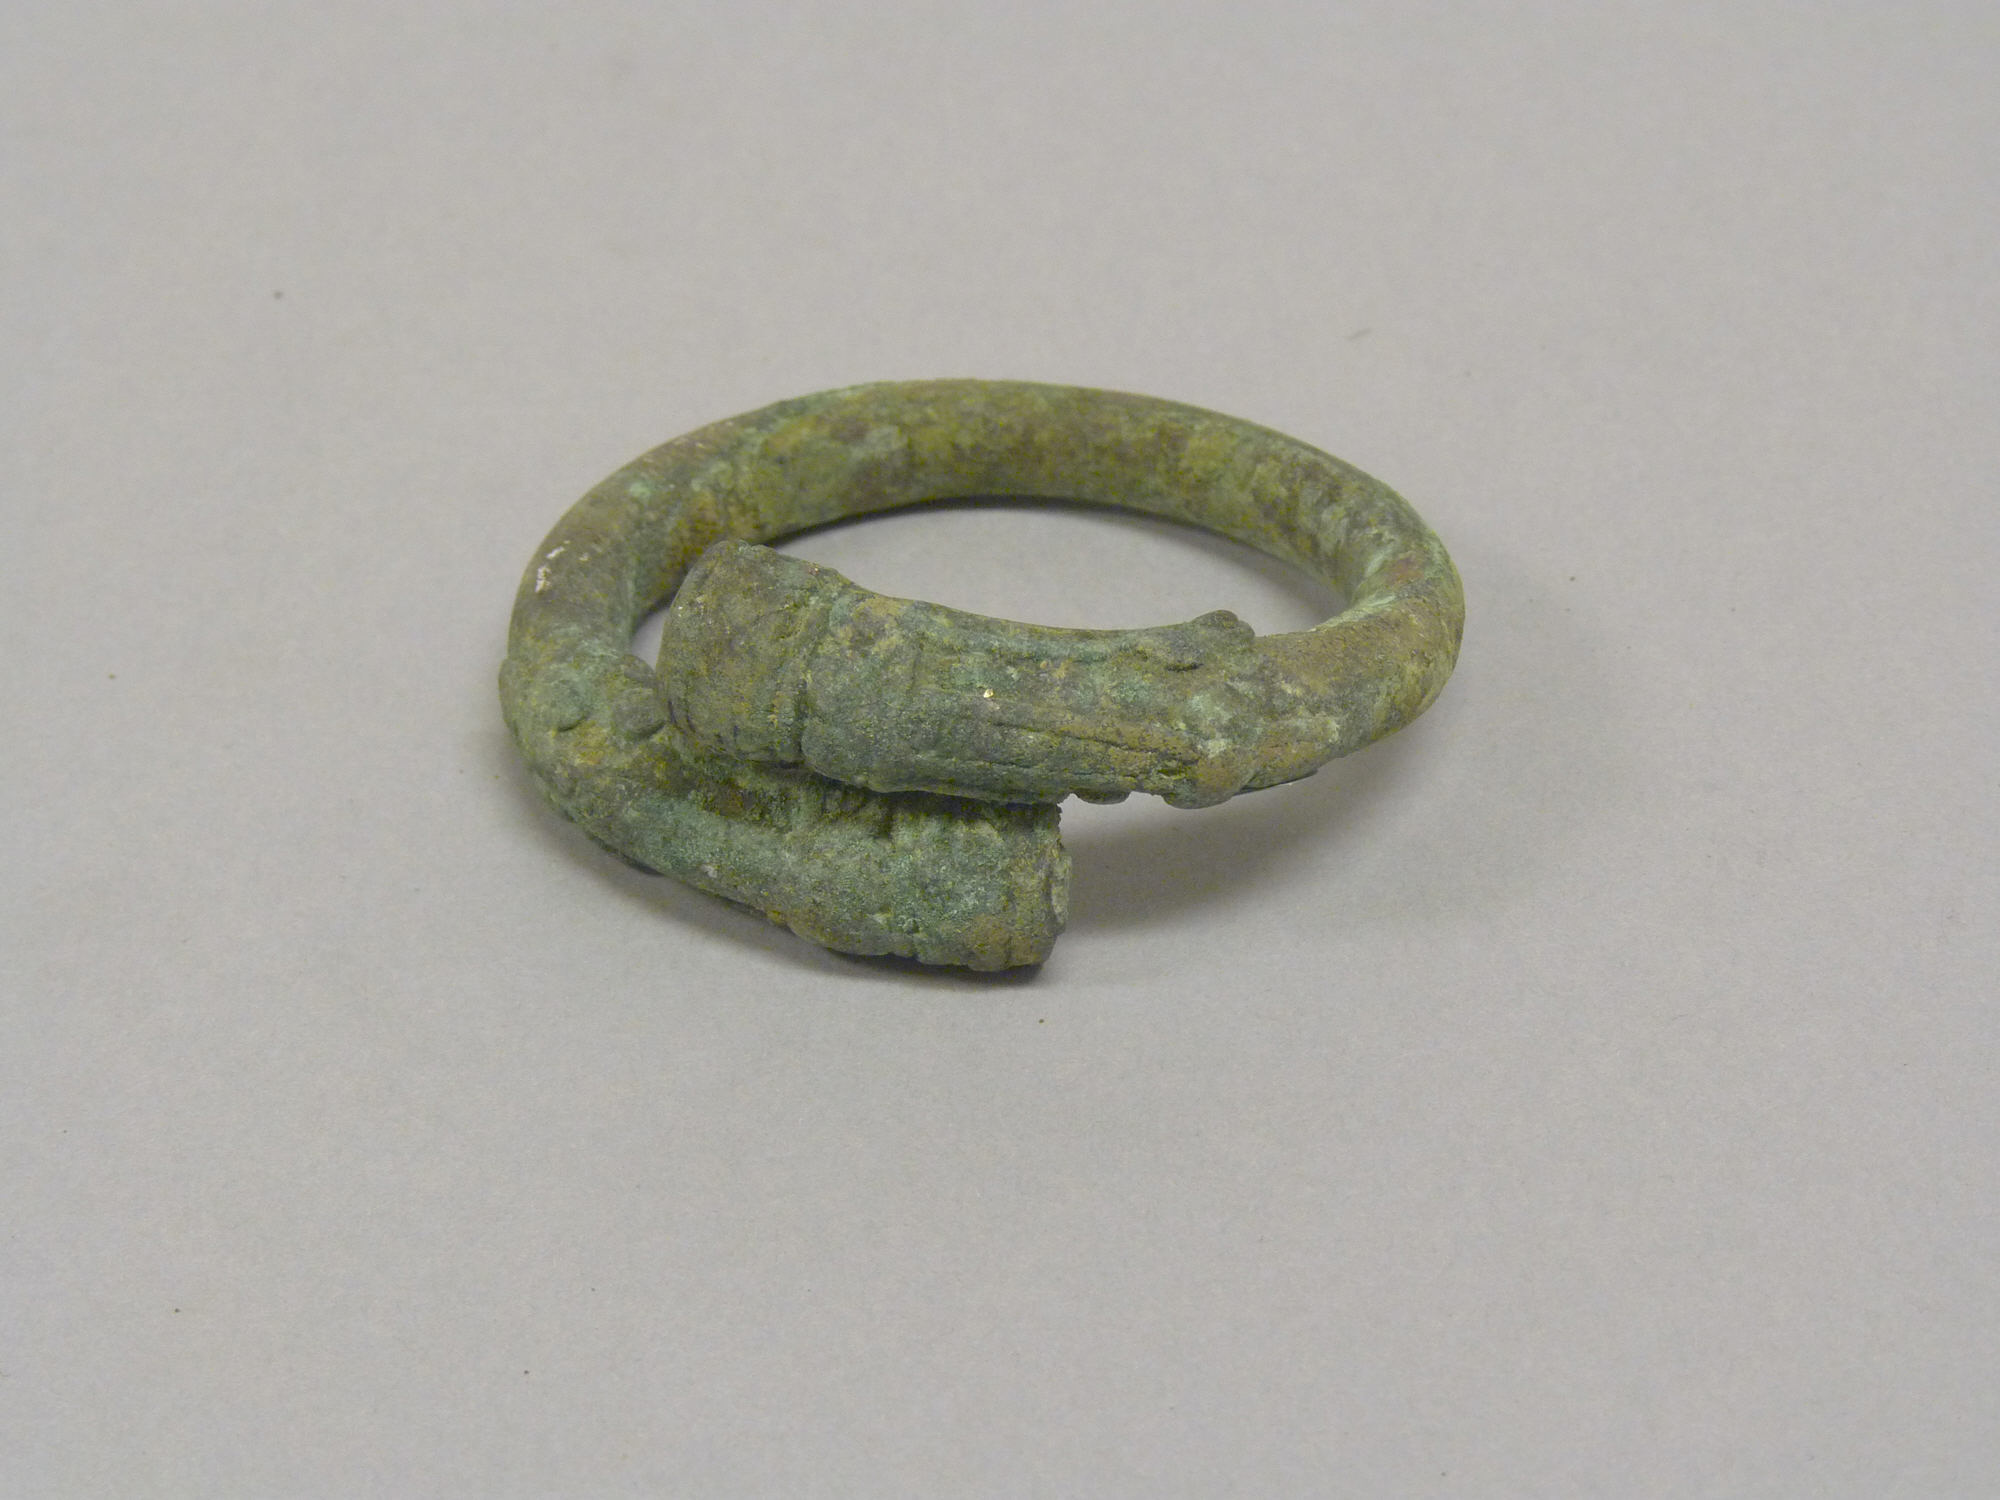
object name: bangle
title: Overlapping Solid Bangle with Applied End Decoration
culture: thai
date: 1000 BCE-400 CE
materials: bronze